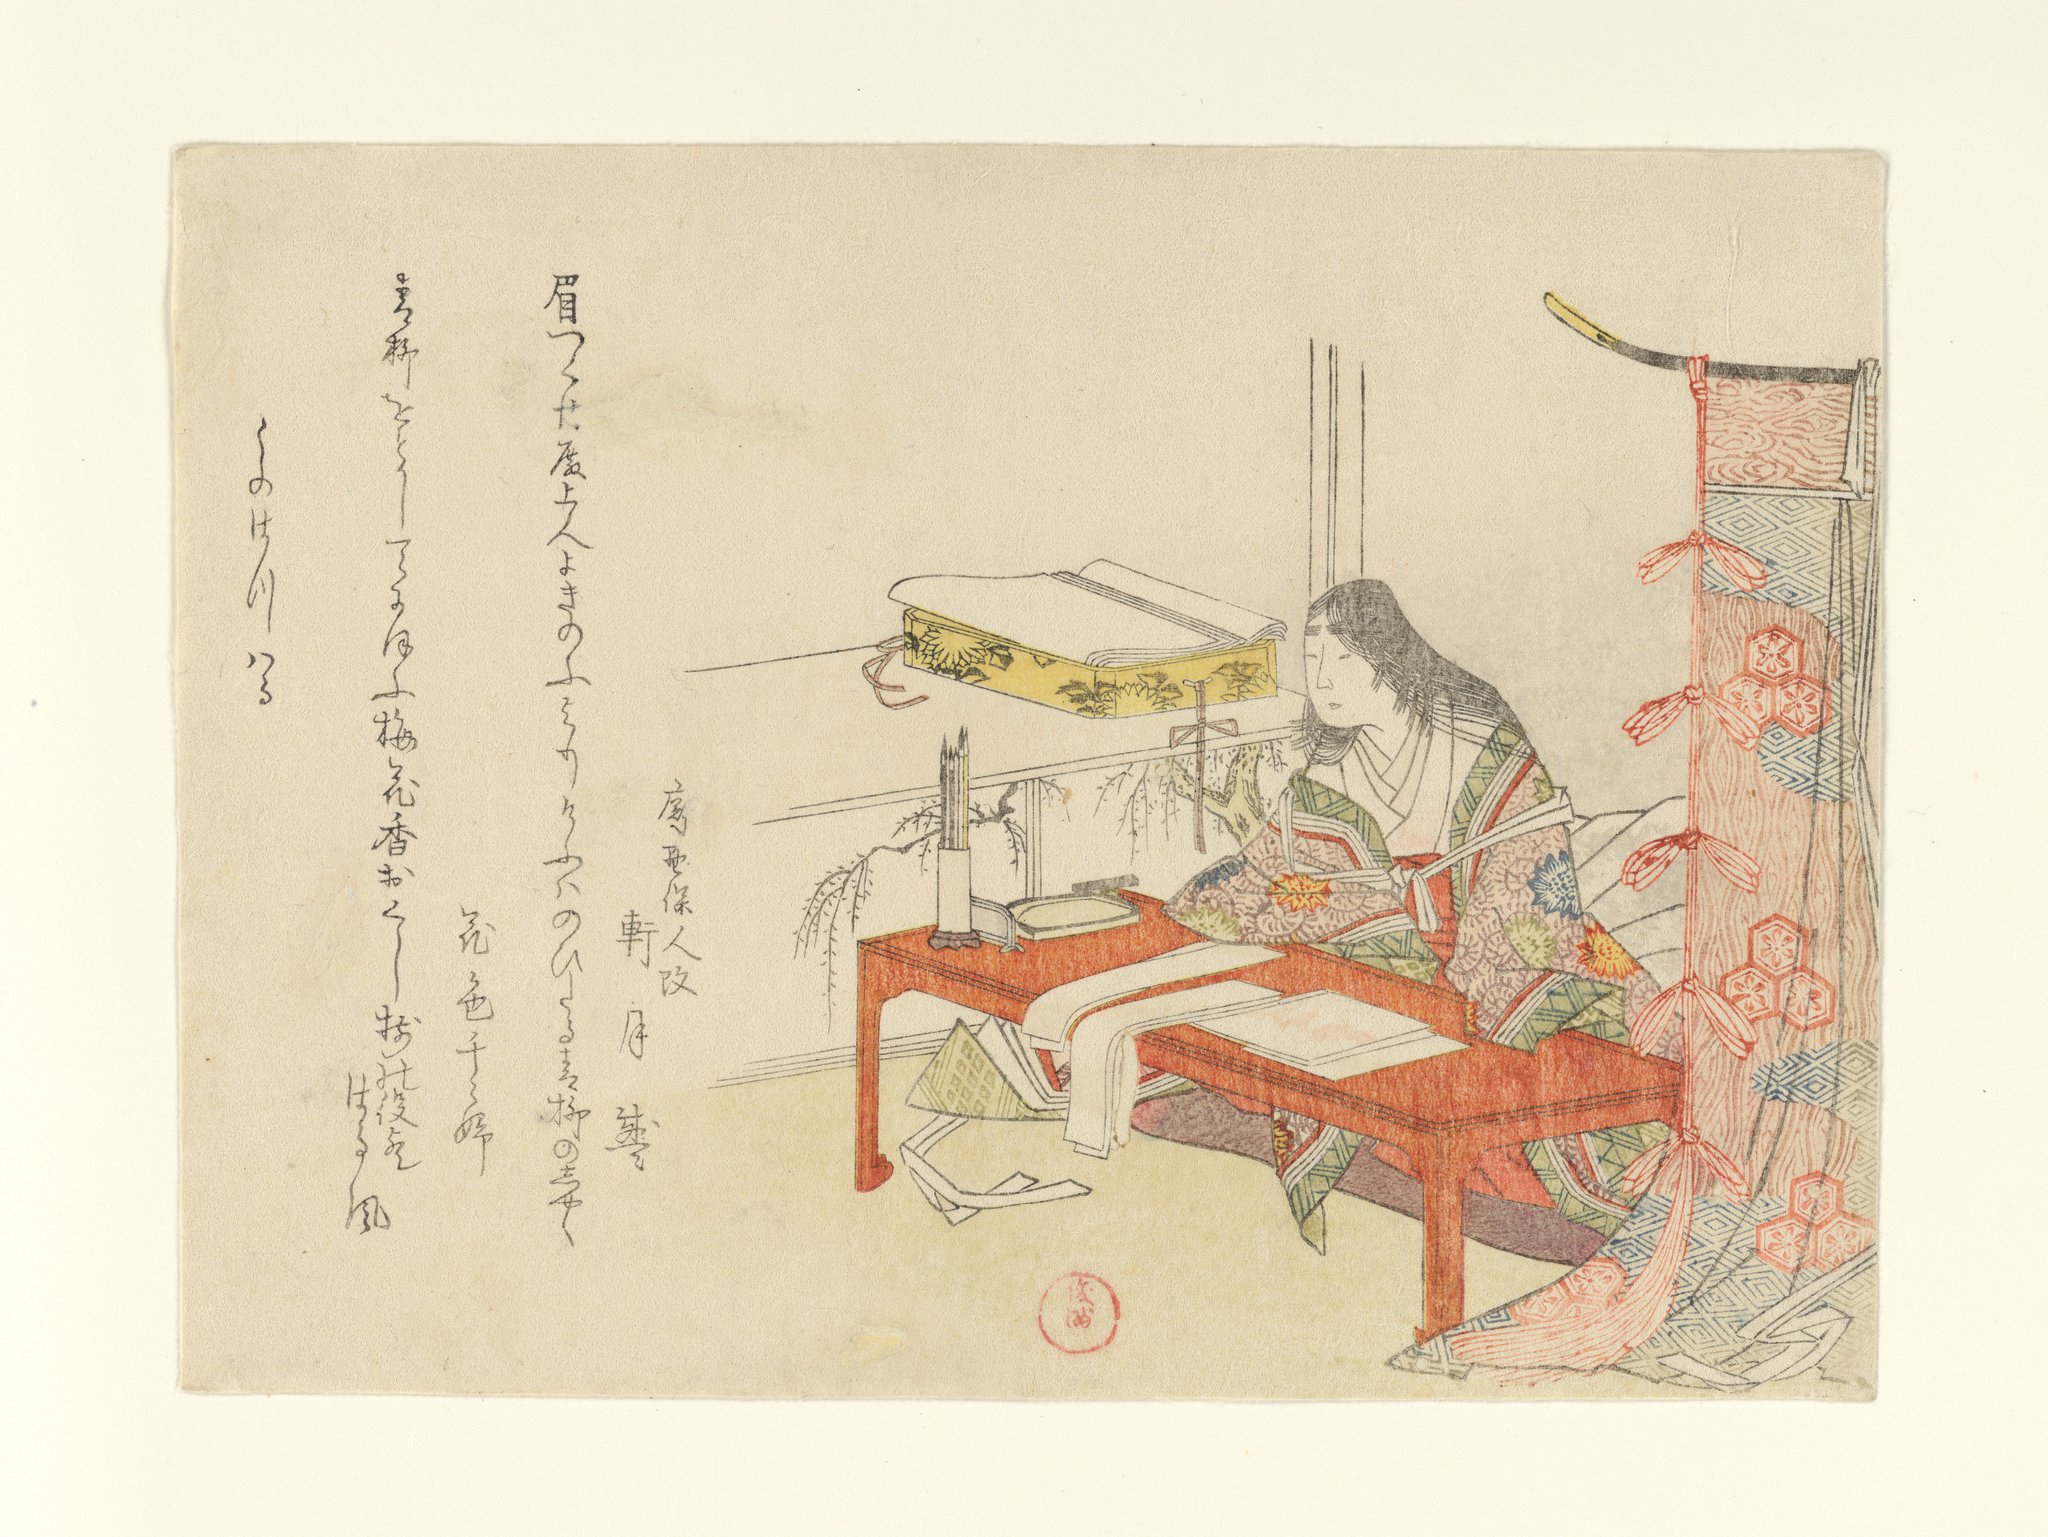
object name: print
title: Court Woman at her Desk with Poem Cards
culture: japanese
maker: kubo shunman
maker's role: artist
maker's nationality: japanese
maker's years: 1757-1820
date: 1795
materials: ink, paper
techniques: surimono, woodblock print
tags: women,desks